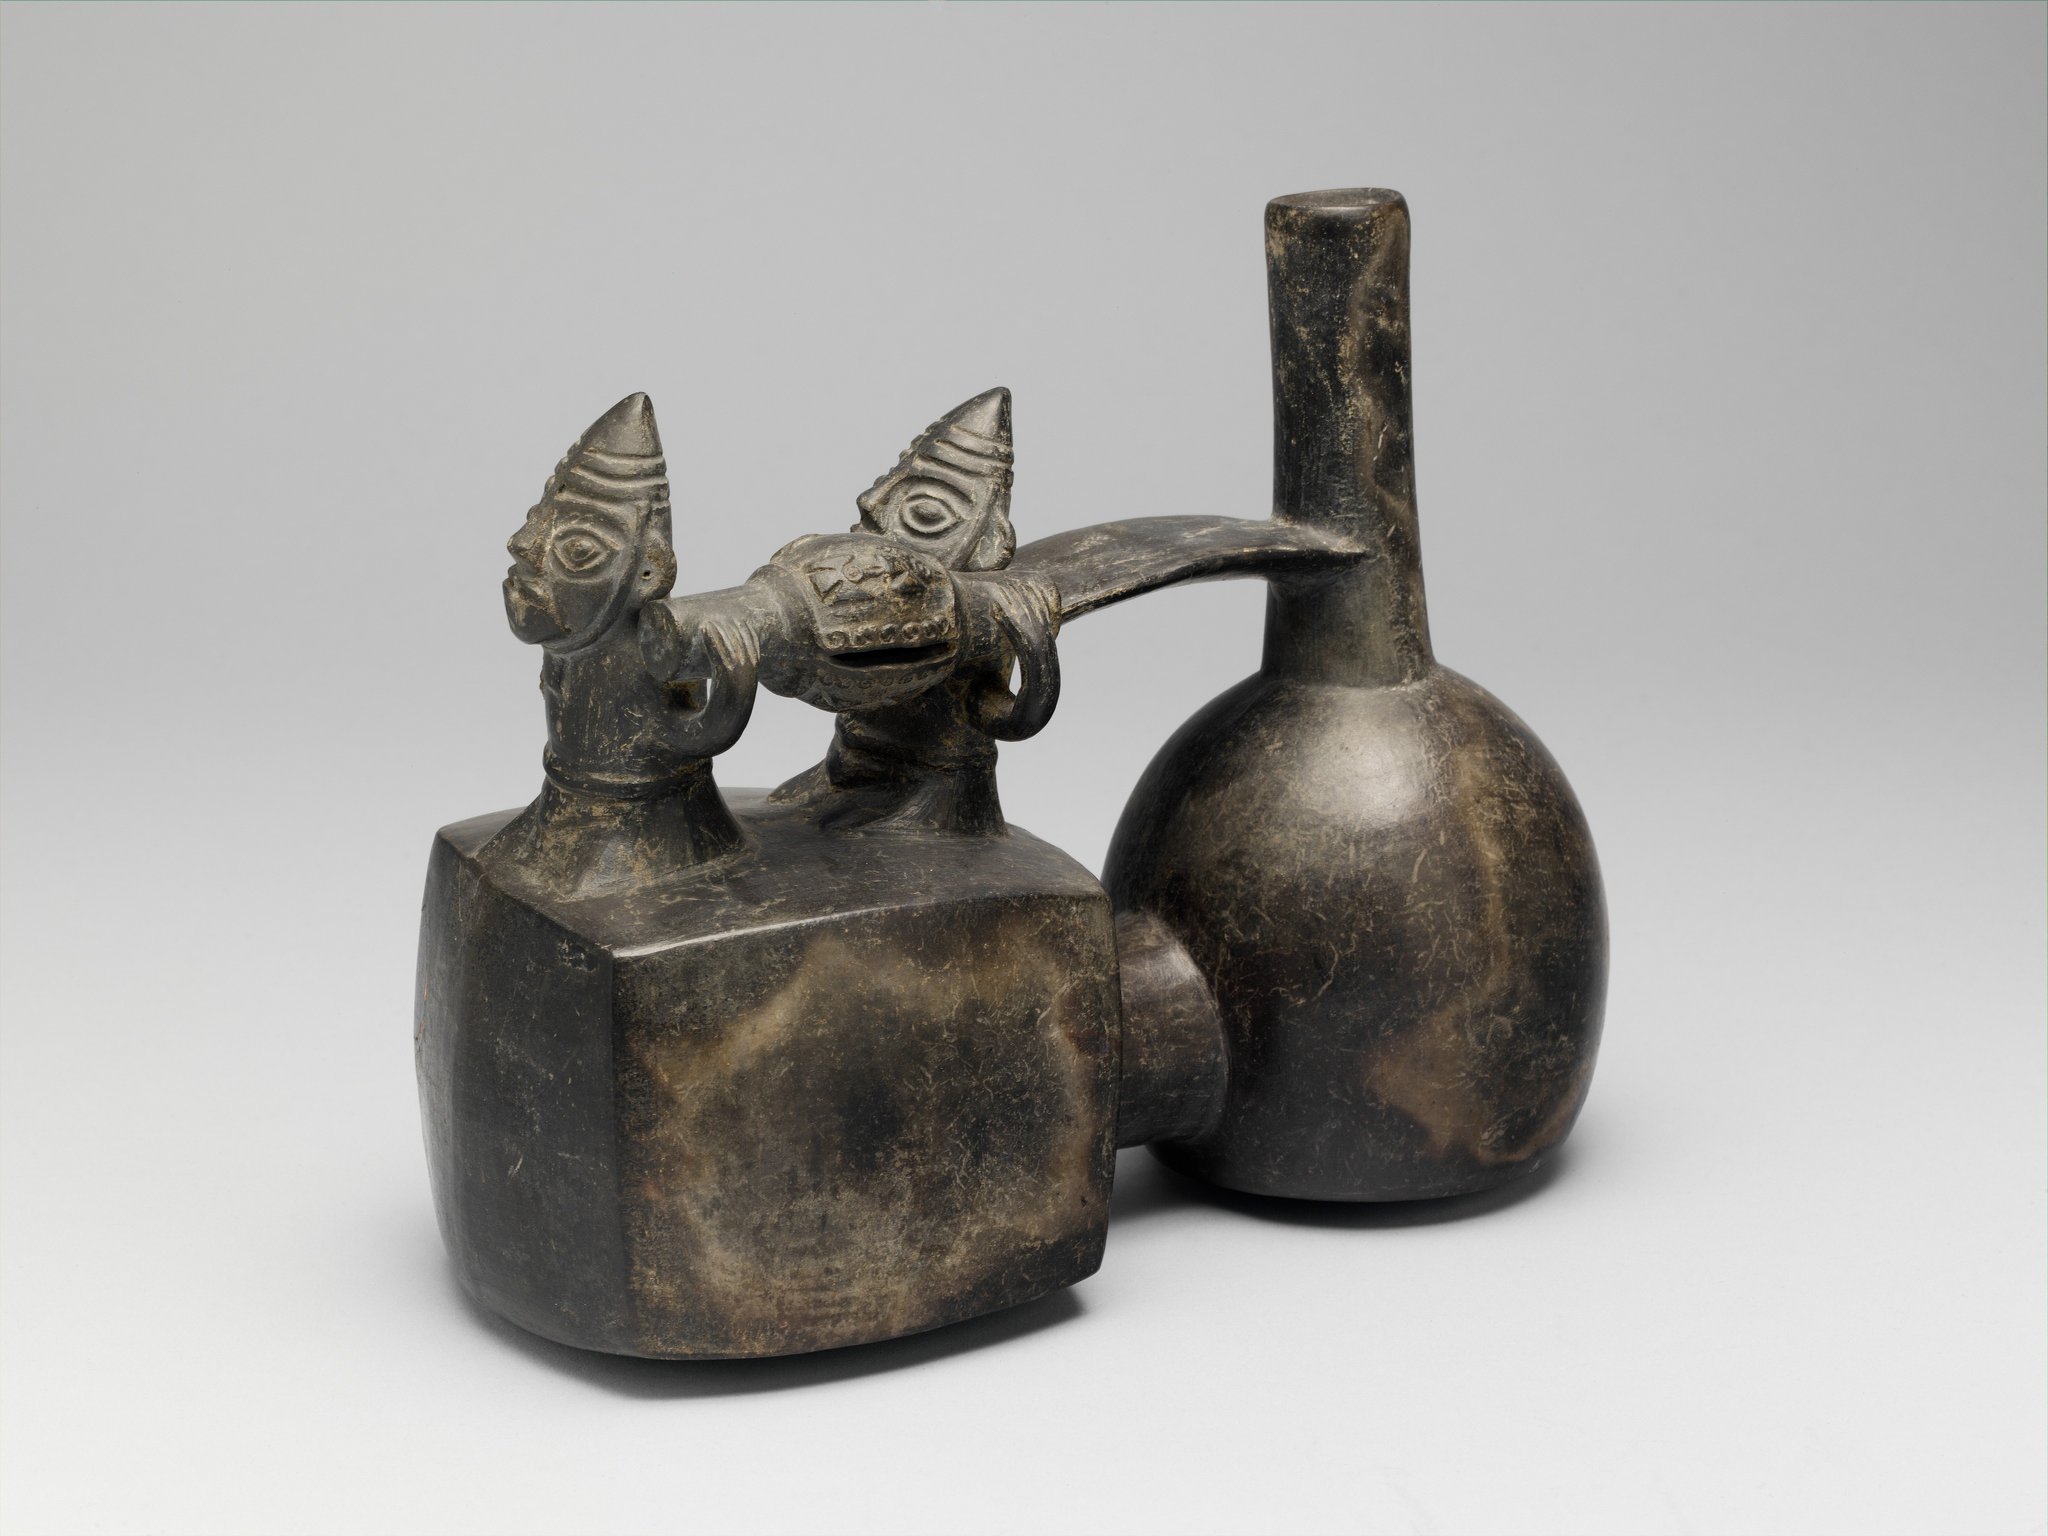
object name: bottle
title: Spout-and-bridge bottle with funerary procession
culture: chimú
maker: chimú artist(s)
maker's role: artist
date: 1100-1470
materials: ceramic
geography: peru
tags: human figures